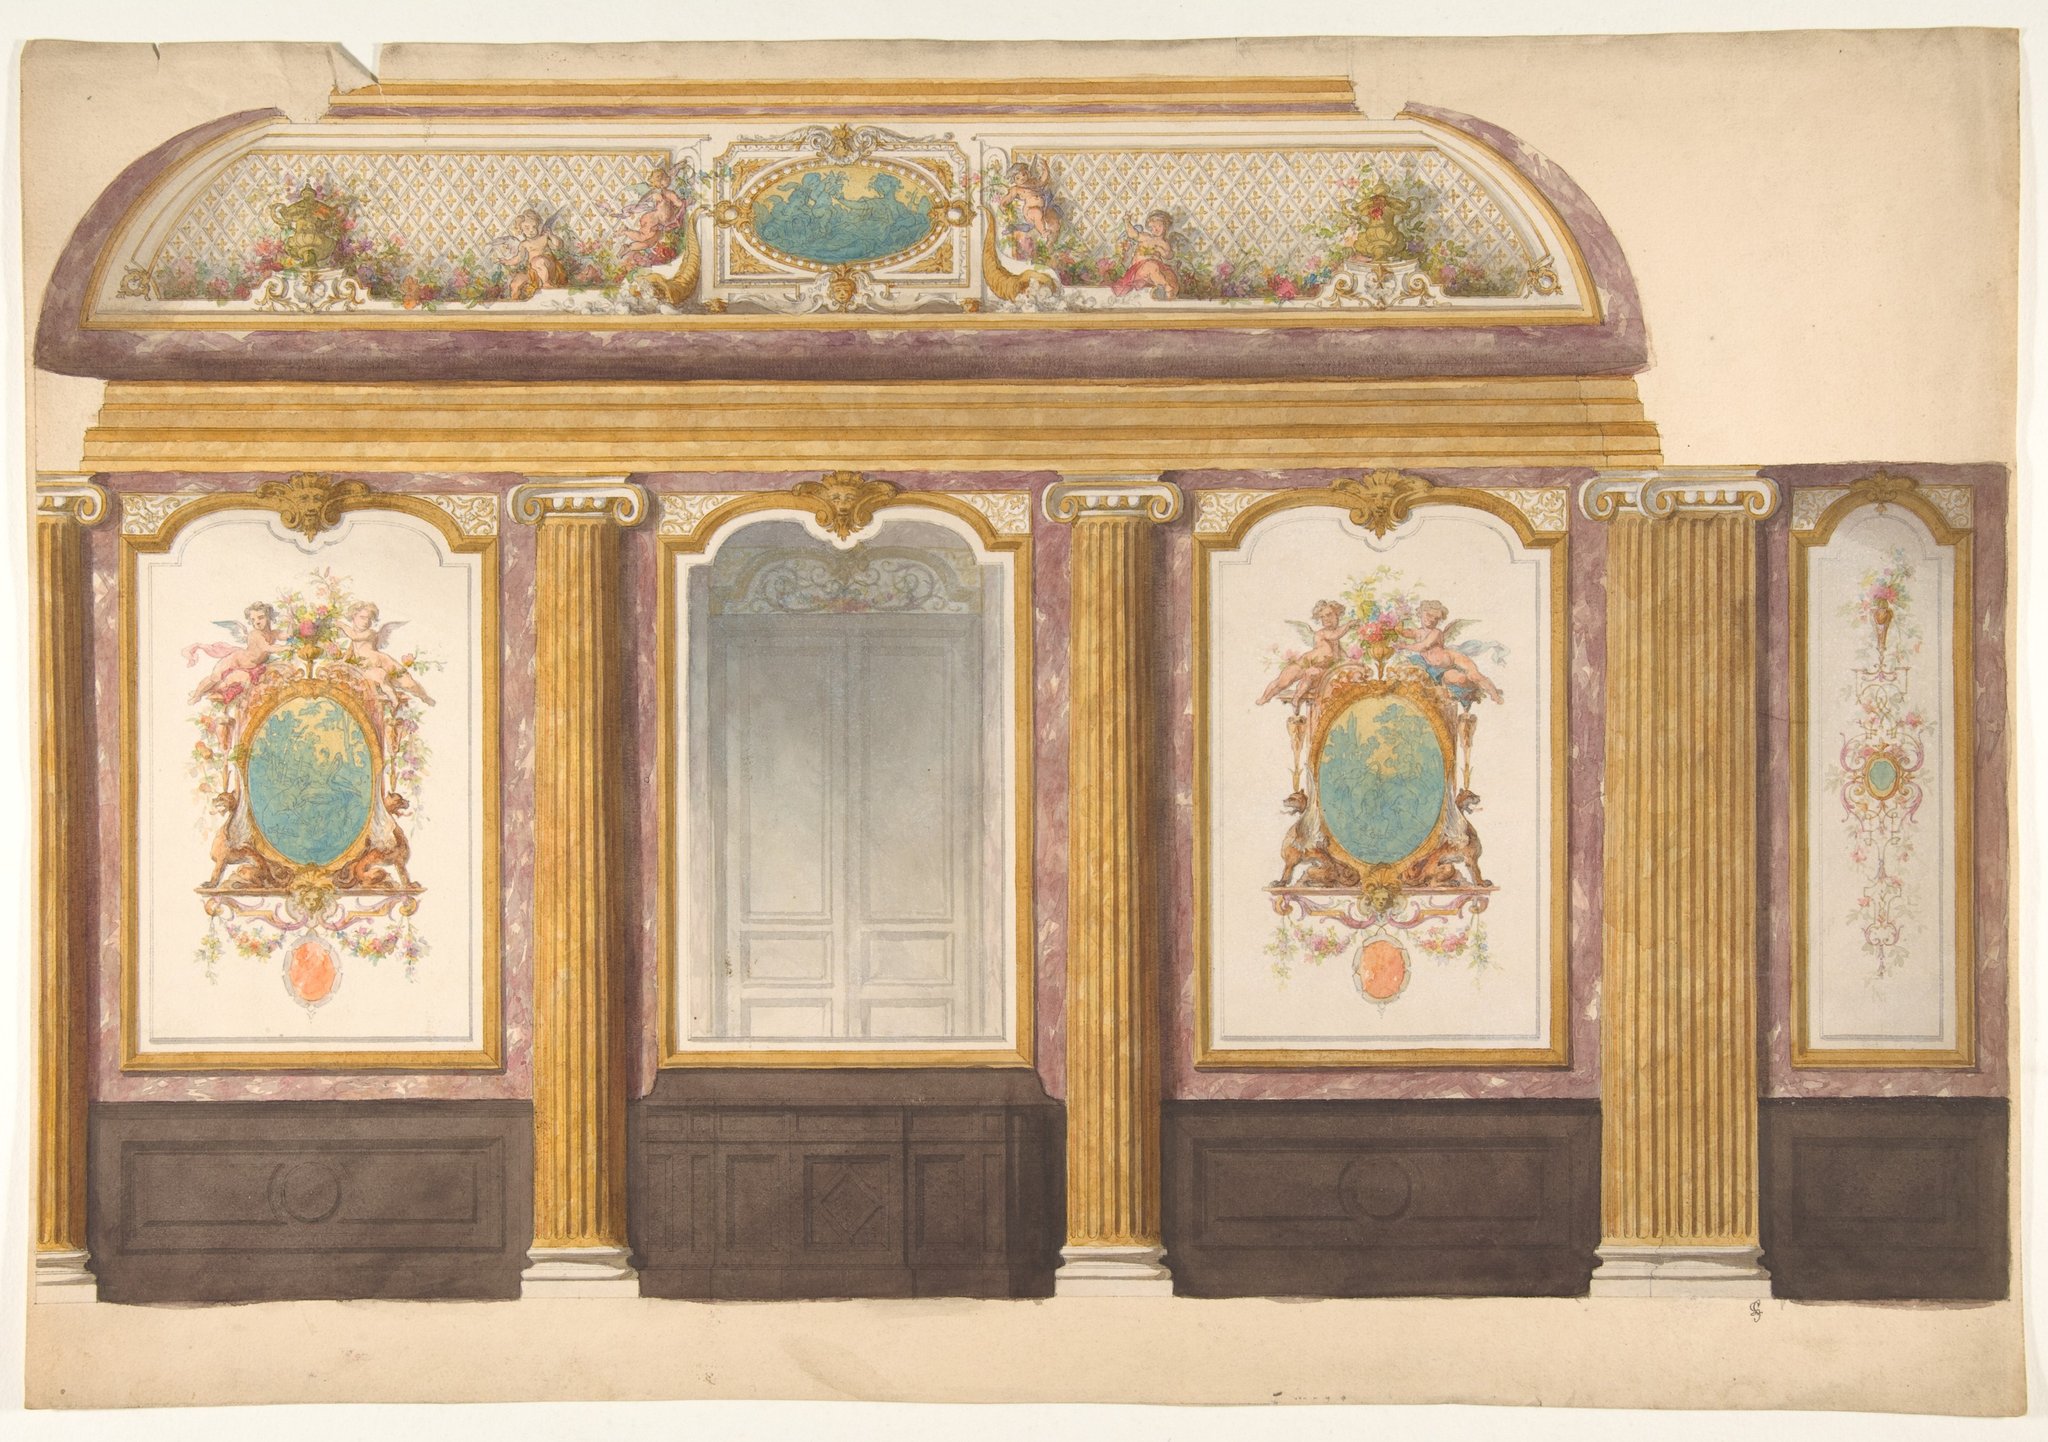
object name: drawing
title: Design for wall panels with putti and flower garlands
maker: jules-edmond-charles lachaise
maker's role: artist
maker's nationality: french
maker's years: 1897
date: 1851-1900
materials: graphite, ink, watercolor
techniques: pen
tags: architecture